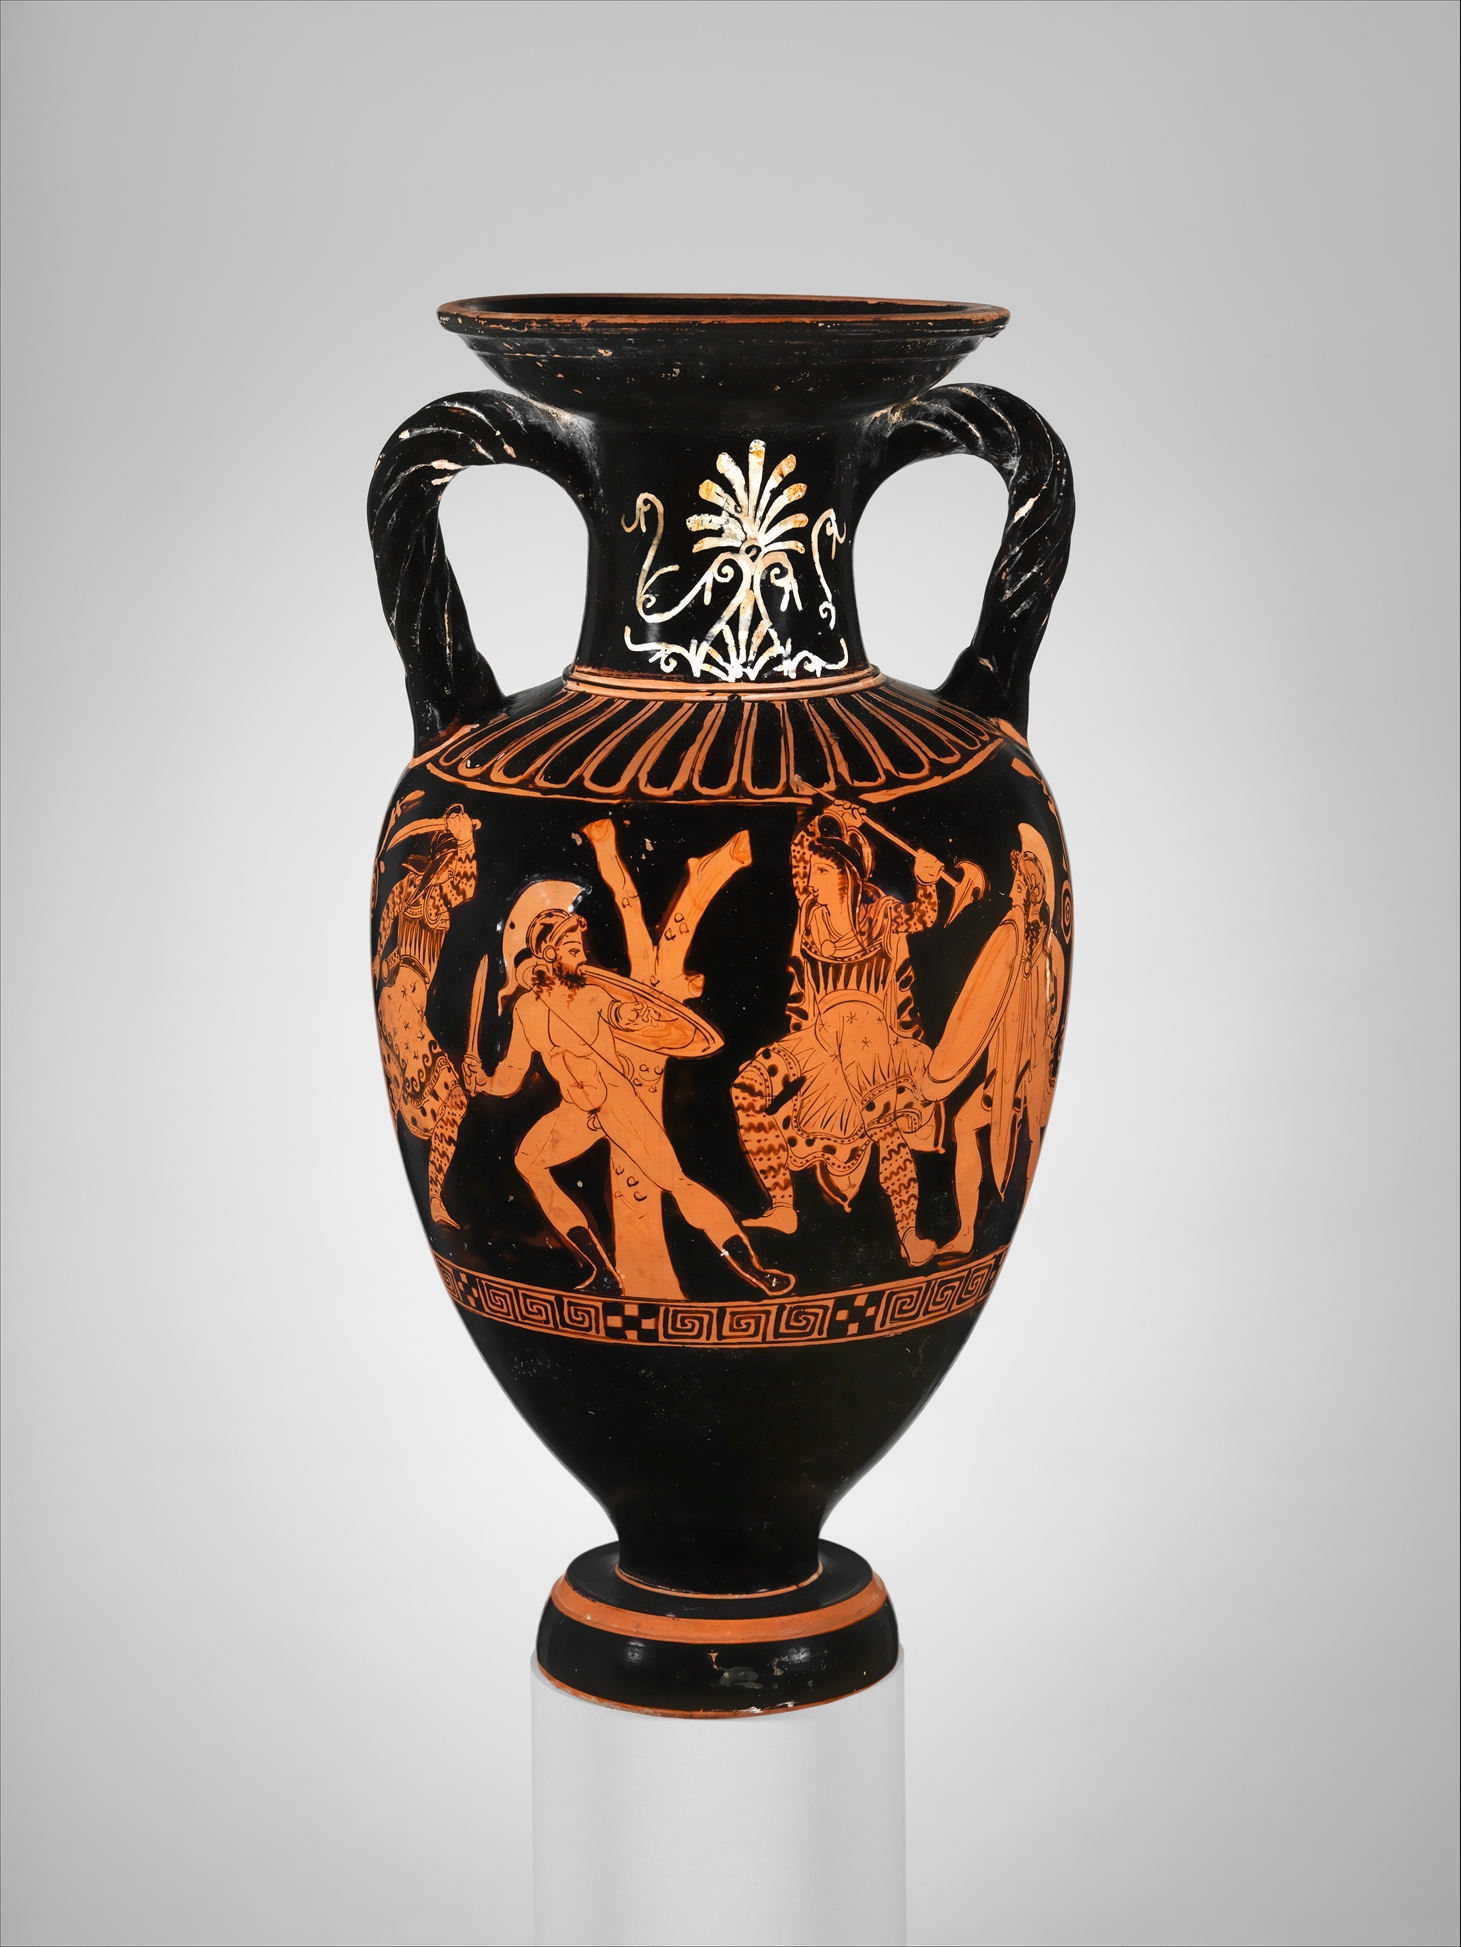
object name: neck amphora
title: Terracotta neck-amphora (jar) with twisted handles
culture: greek, attic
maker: suessula painter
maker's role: artist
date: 400 BCE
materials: terracotta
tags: human figures,shields,male nudes,amazons